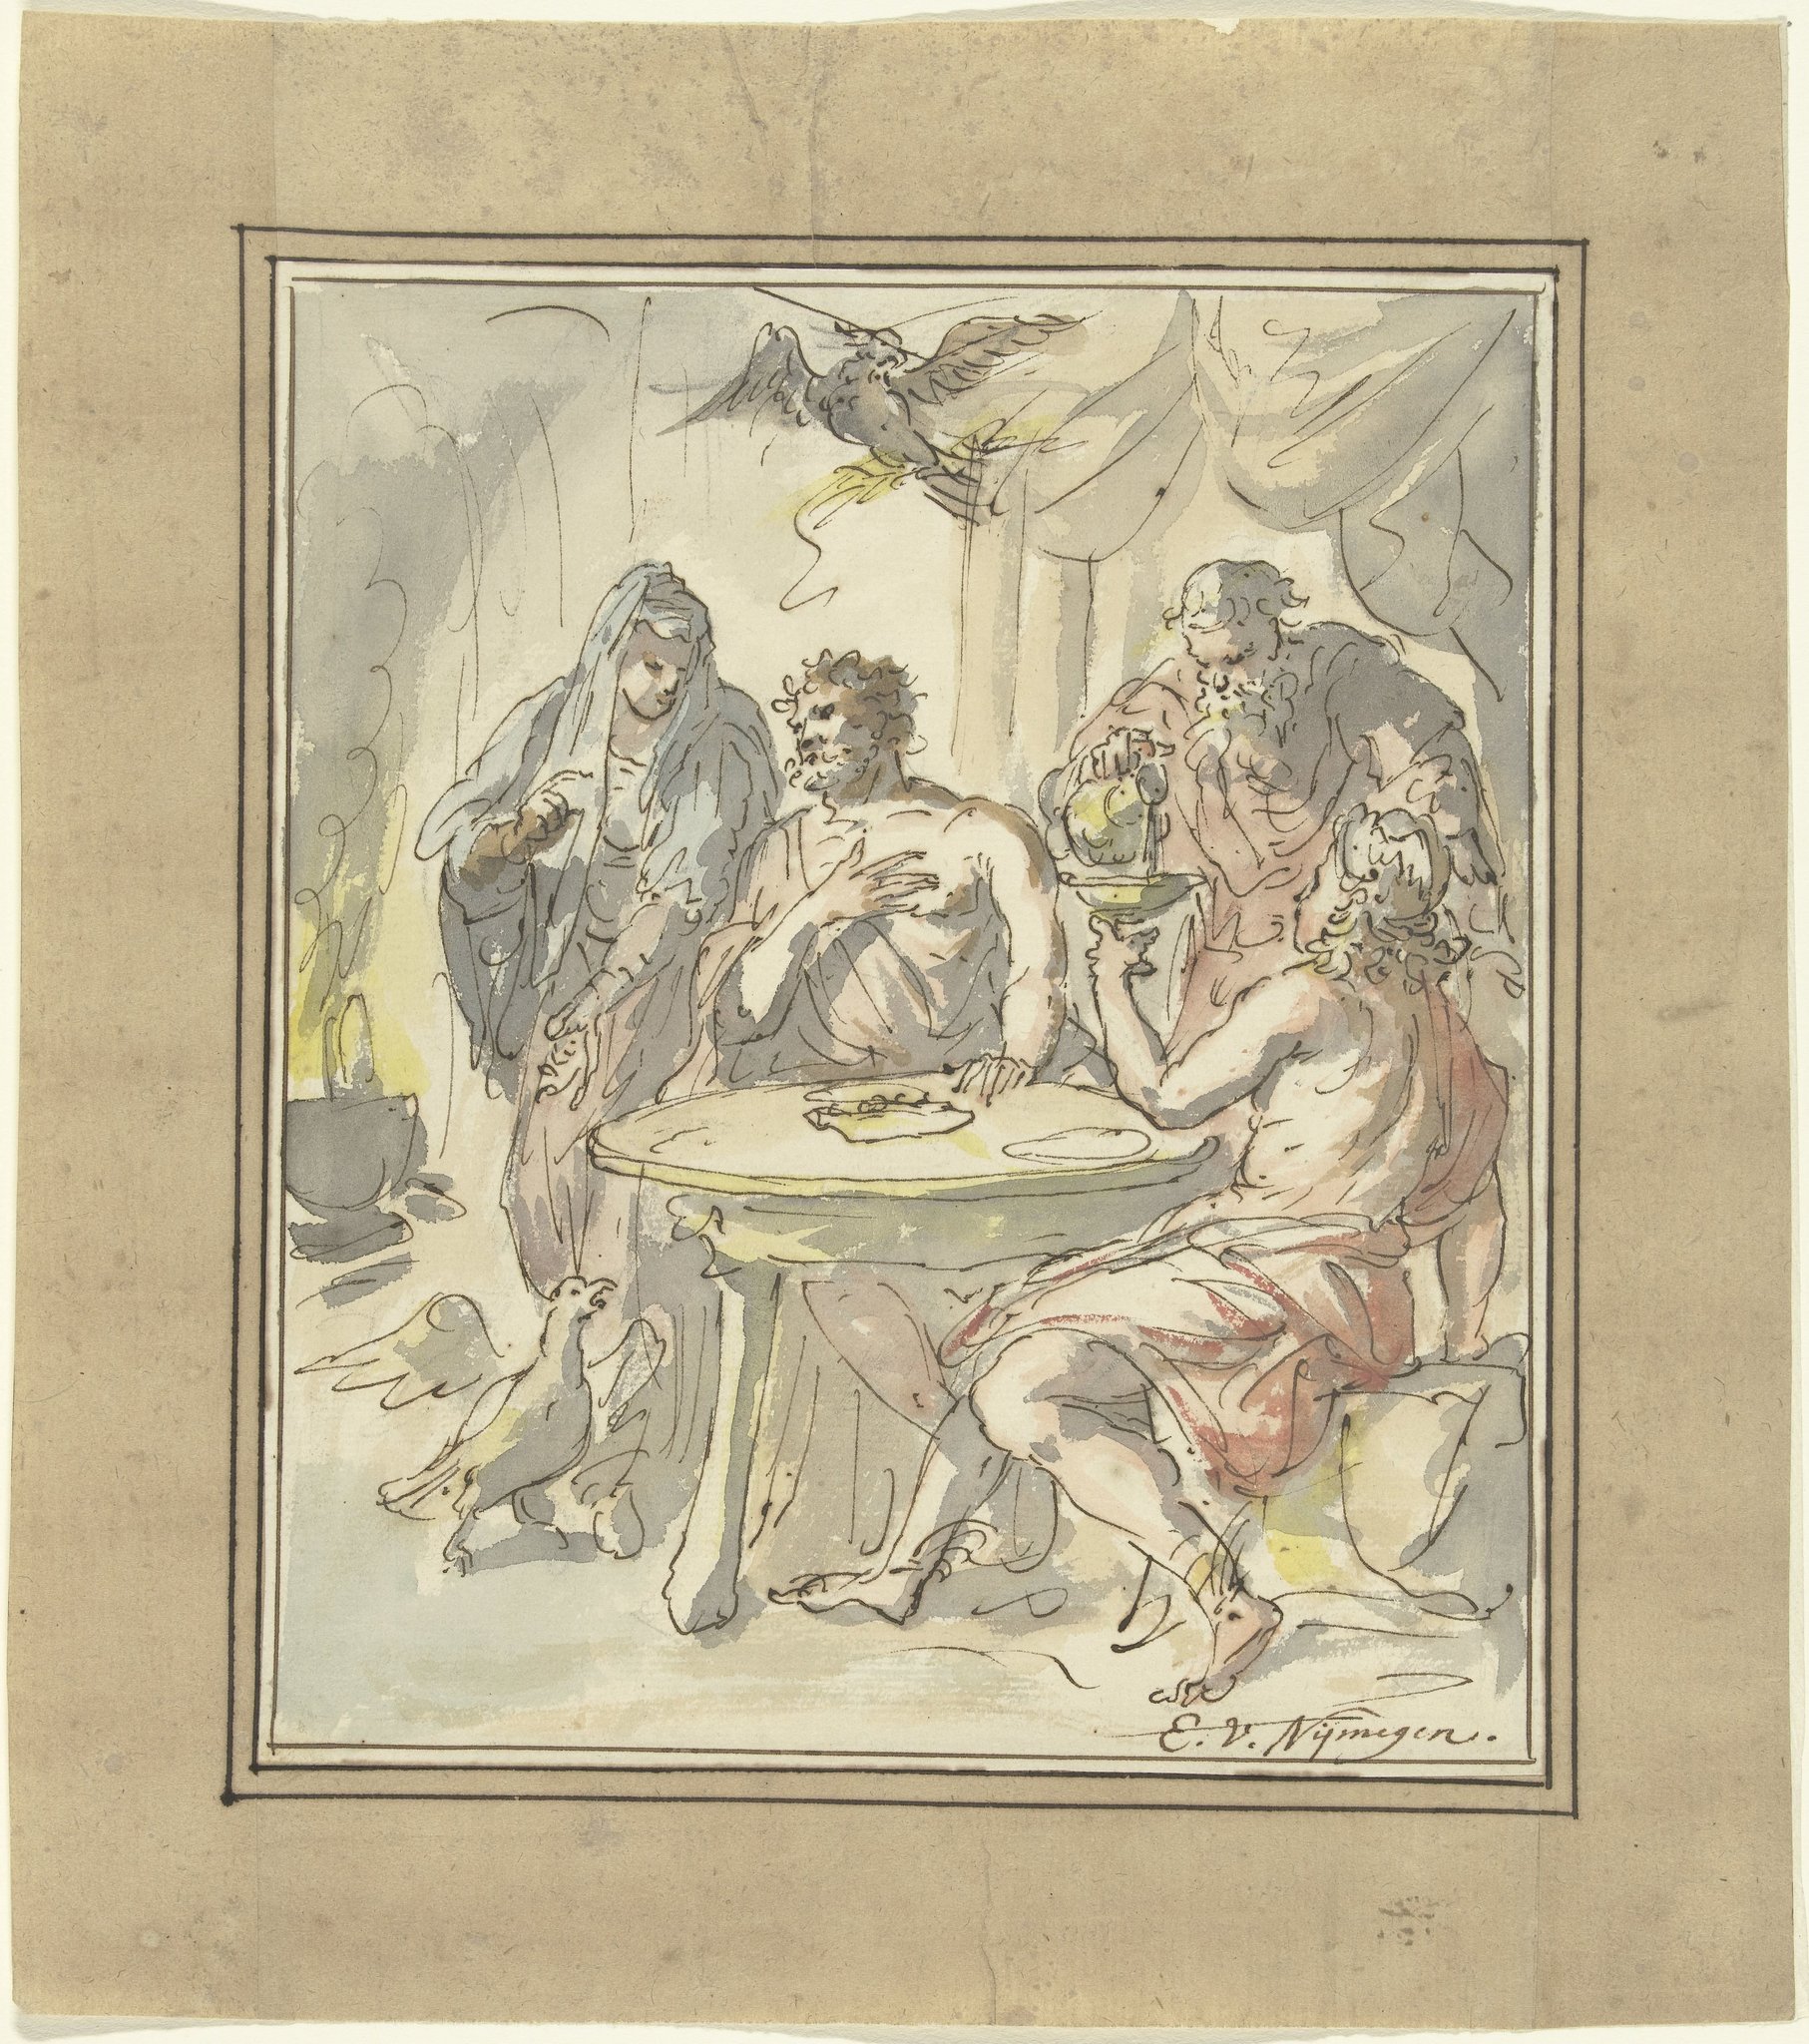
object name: watercolor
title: Philemon en Baucis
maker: elias van nijmegen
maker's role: draughtsman, painter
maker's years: 1667-1755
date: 1677-1755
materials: ink, paper, pencil, watercolor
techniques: brush, pen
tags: philemon and his wife baucis hospitably entertain jupiter and mercury in travellers' guise; possibly a goose, which they try to kill for the occasion, flies to the visitors for refuge